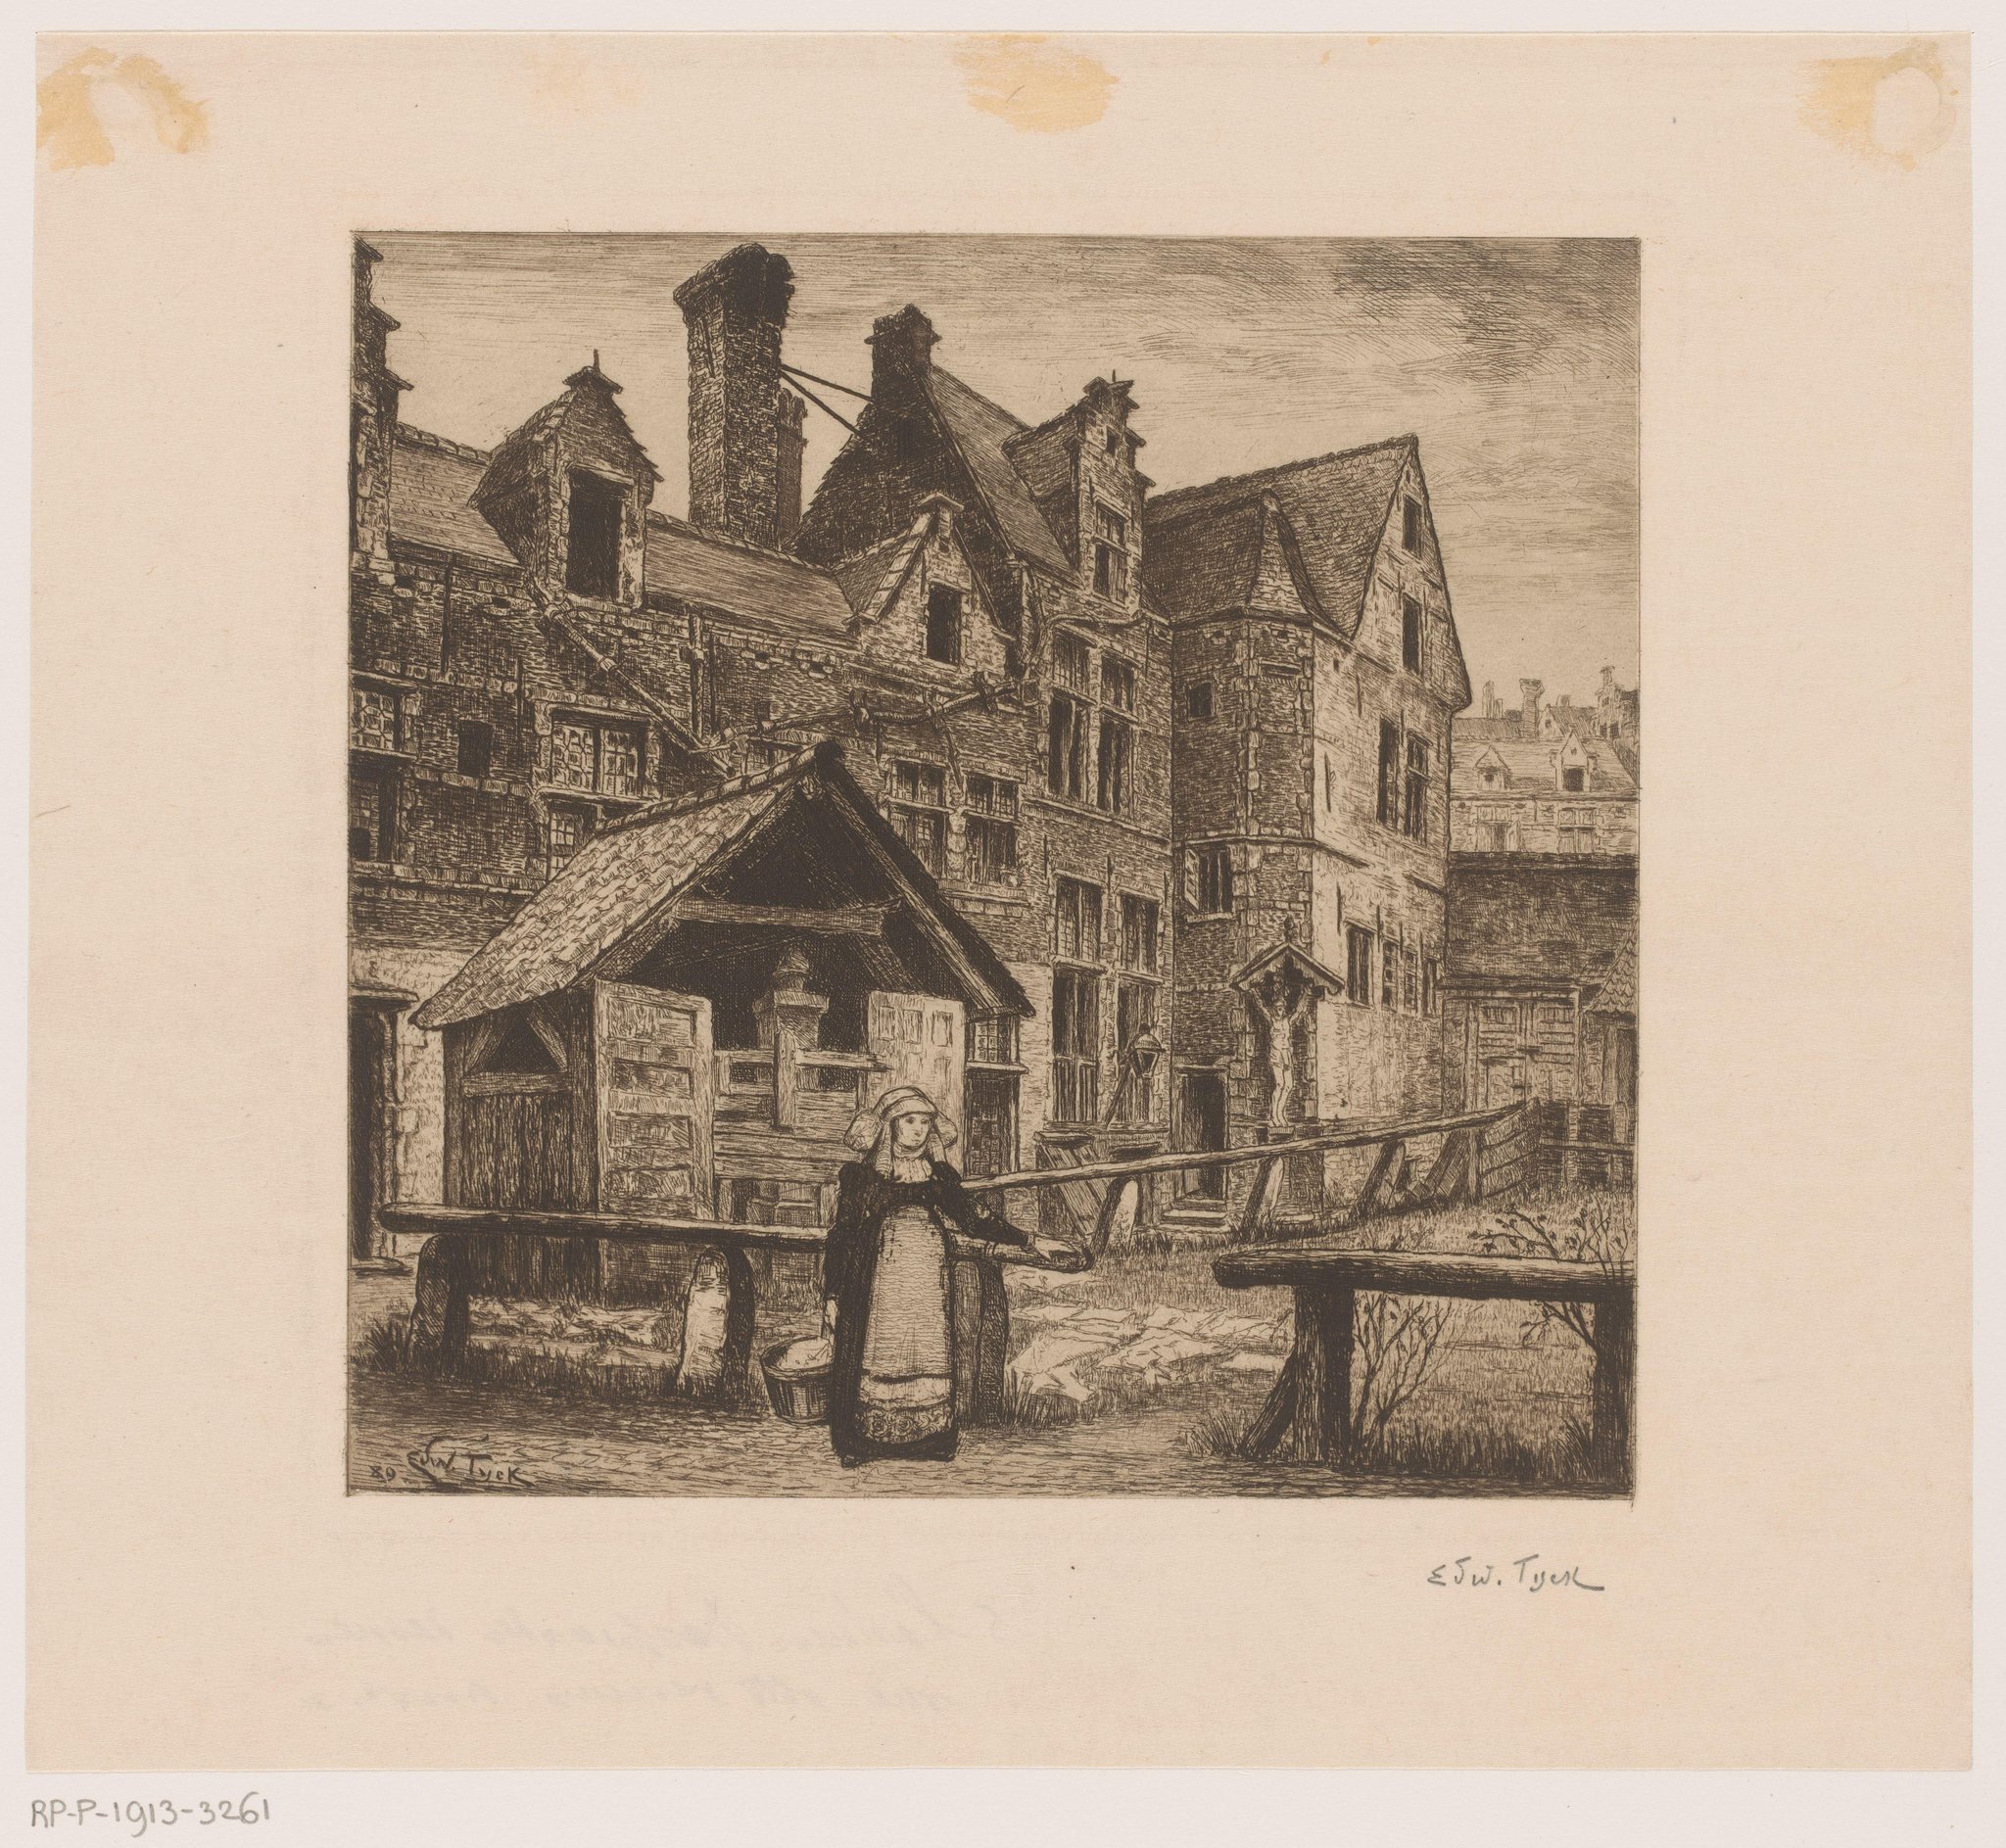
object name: print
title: Gezicht op de binnenplaats van het St. Anna Gasthuis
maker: edouard tyck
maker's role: print maker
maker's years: 1847-1922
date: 1889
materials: paper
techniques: drypoint, etching, intaglio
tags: nun(s), hospital, antwerp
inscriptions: annotation: ‘L'ancien hospice des dames/ rue otto venius Anvers’, collector's mark: Lugt 2228, workshop stamp: ‘Antwerpsche Etsers 1880’